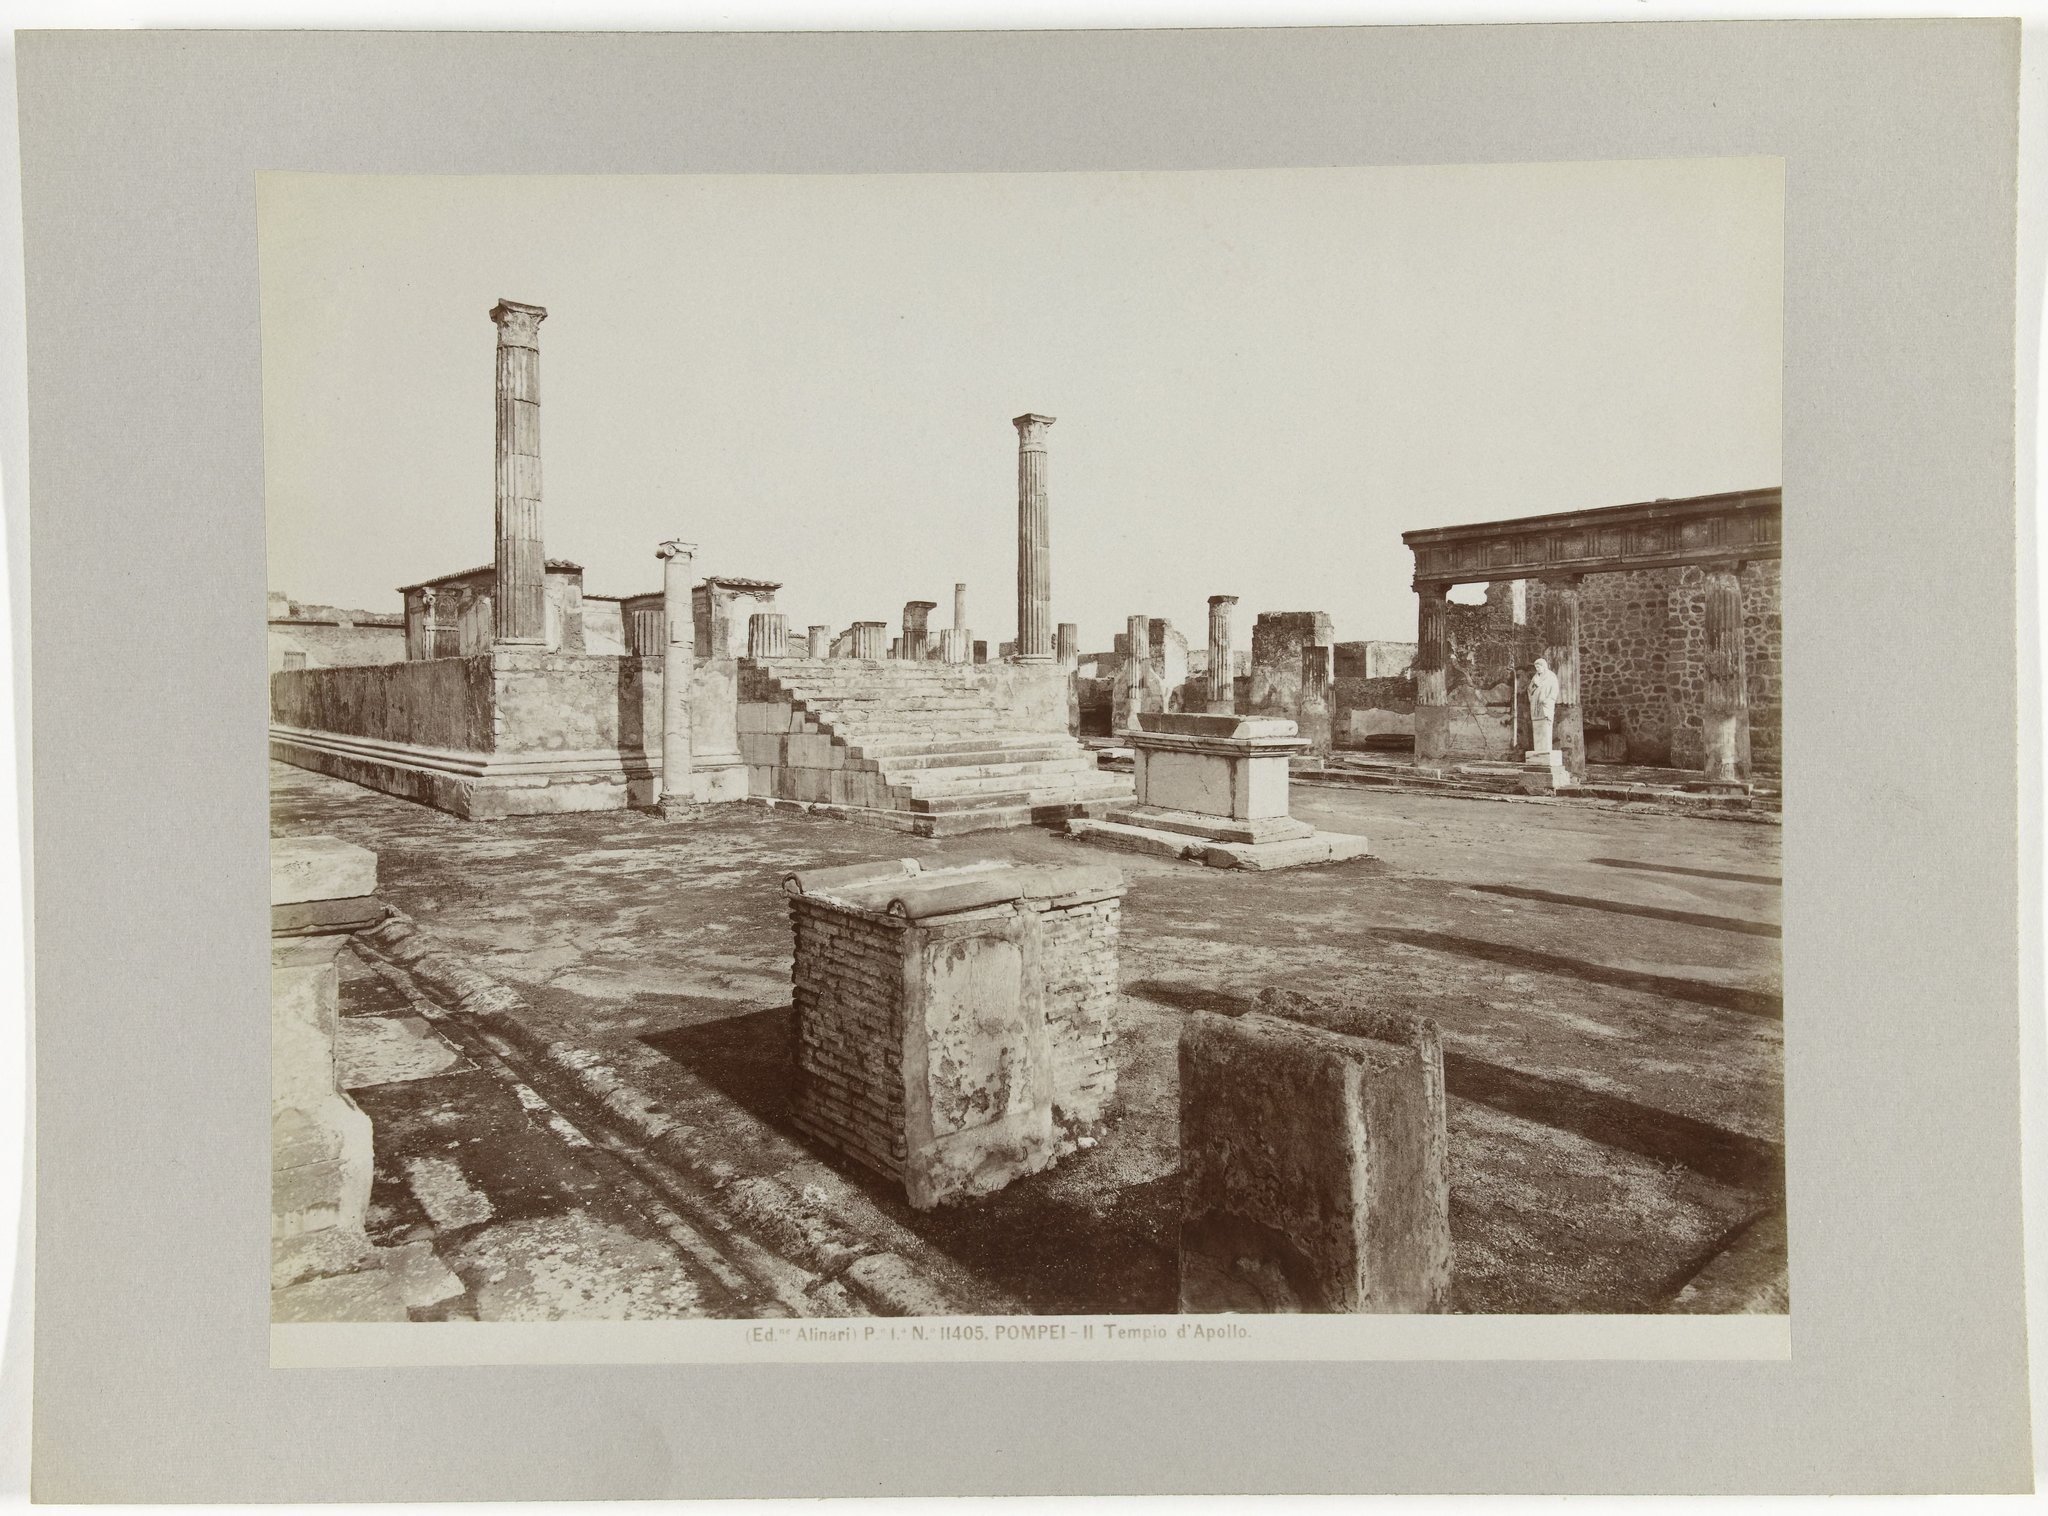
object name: photograph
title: Tempel van Apollo te Pompeï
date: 1880-1895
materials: cardboard, paper, photographic support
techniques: albumen print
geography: florence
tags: ruin of a building ~ architecture, temple, shrine ~ non-christian religions, pompeii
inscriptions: number: ‘69.’